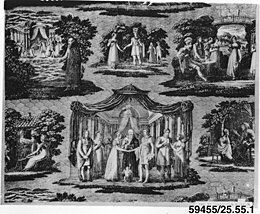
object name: piece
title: "La Trève de Dieu"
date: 1820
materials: linen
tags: men,women,trees